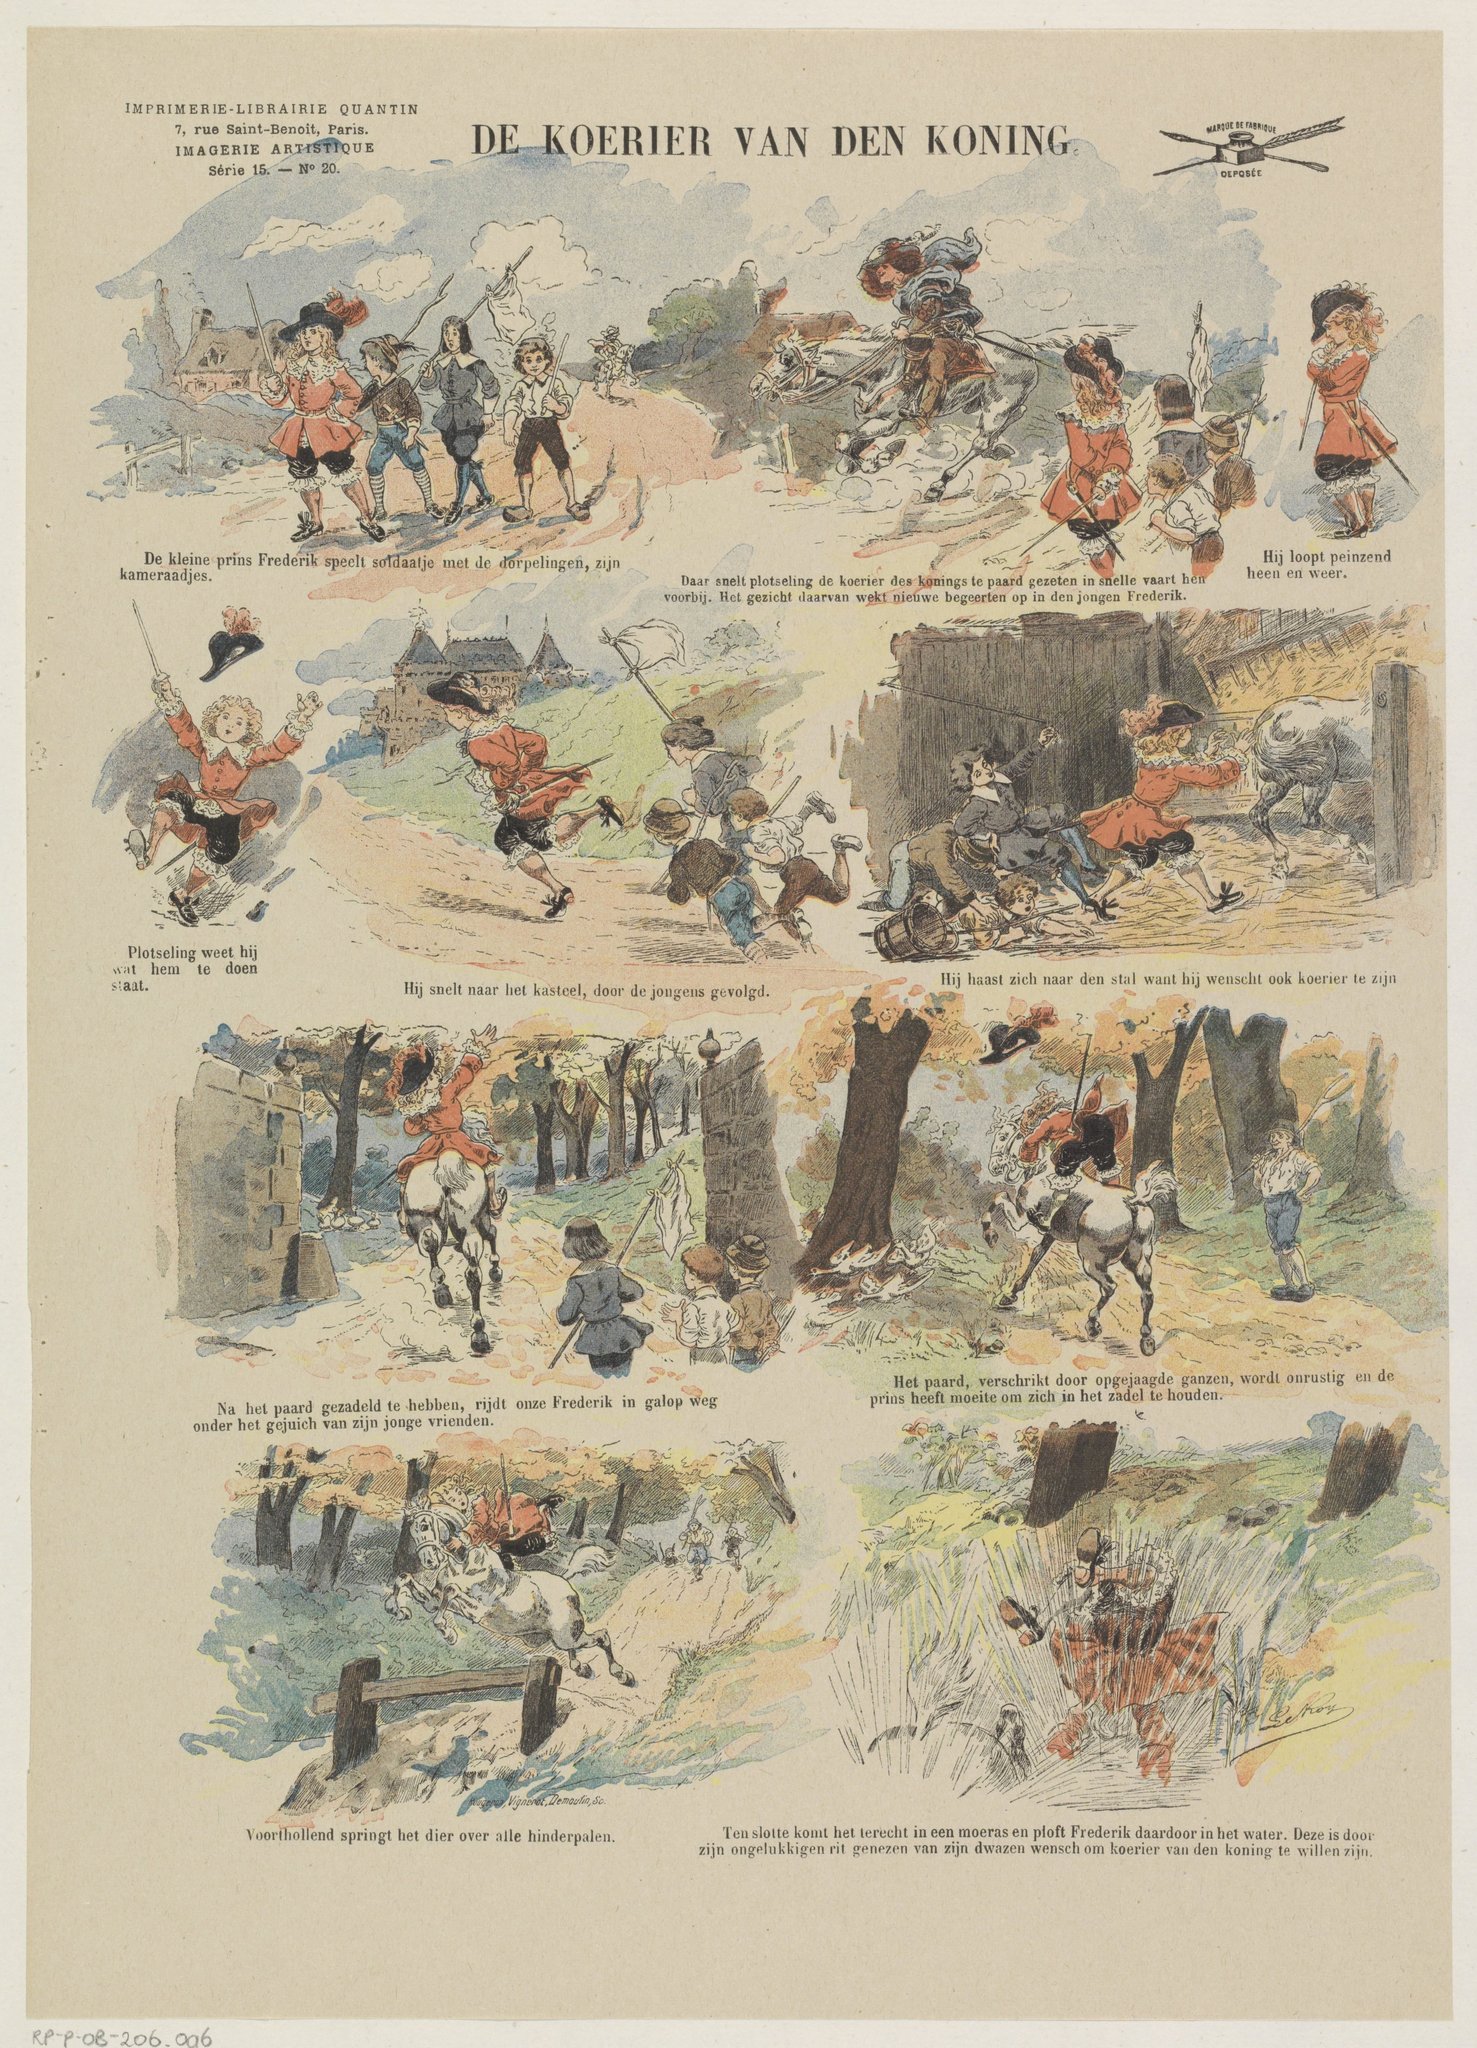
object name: print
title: De koerier van den koning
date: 1876-1890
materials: paper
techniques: lithograph, letterpress printing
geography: paris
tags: riding a horse, ass, or mule; rider, horseman, children's games and plays, messenger, tales and fairy tales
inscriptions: collector's mark: Lugt 2760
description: Blad met 10 voorstellingen van de kleine prins Frederik die de koerier van de koning te paard ziet. Hij besluit ook koerier te willen worden. Na een dolle rit op een paard eindigt de prins in de sloot. Onder elke afbeelding een onderschrift. Genummerd linksboven: Série 15. - No. 20.